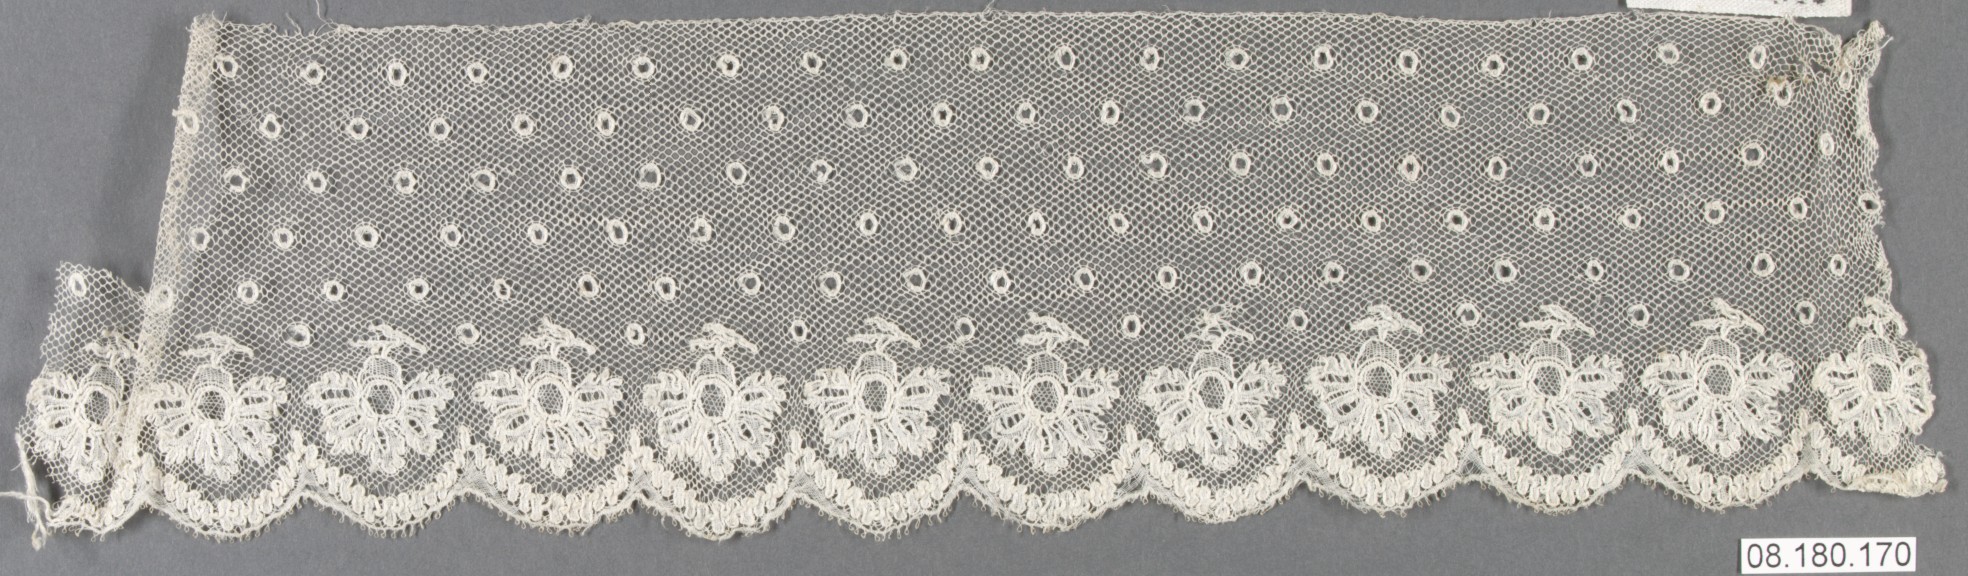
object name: fragment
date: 1801-1900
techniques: lace